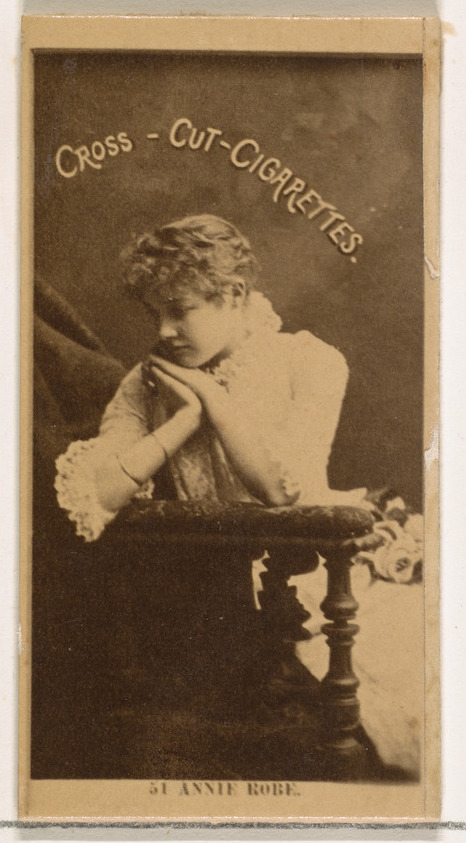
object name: print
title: Card Number 51, Annie Robe, from the Actors and Actresses series (N145-2) issued by Duke Sons & Co. to promote Cross Cut Cigarettes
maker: w. duke, sons & co.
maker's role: publisher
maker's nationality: american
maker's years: 1870-1920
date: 1880-1889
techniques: albumen silver print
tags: portraits,women,actresses